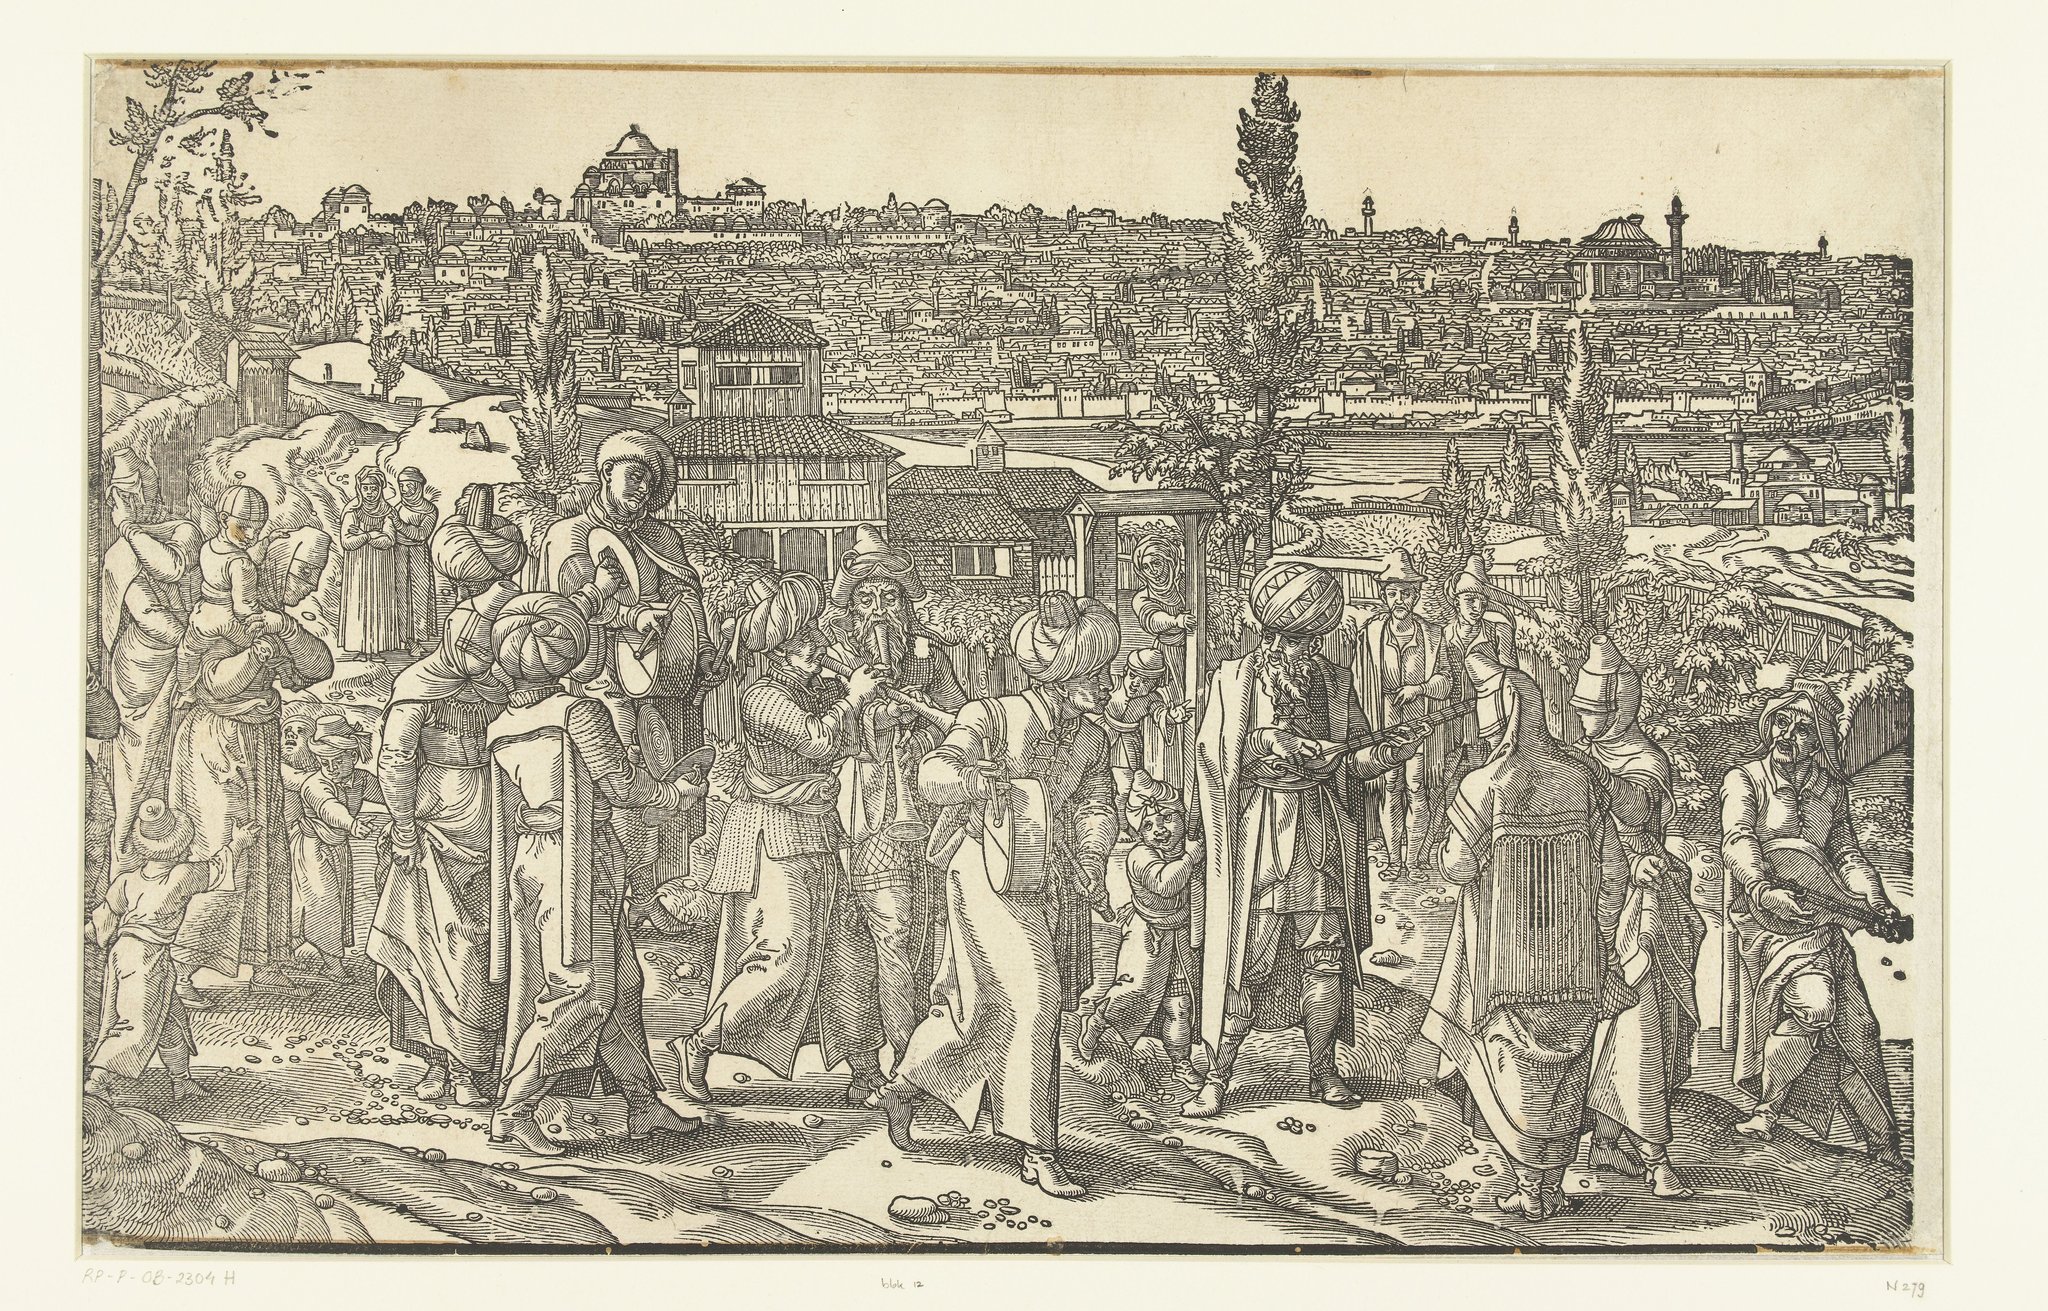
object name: print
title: Bruiloftsoptocht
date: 1553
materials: paper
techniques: woodcut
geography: low countries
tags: asiatic races and peoples: turks, ritual music and dancing ~ islam, mohammedanism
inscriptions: collector's mark: Lugt 240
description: Twaalfde blok van veertien, vormen samen een fries van zeven afbeeldingen met de zeden en gewoonten van de Turken. Bruiloftsoptocht met gesluierde vrouwen, kinderen en muzikanten op de heuvels van Kassim-Pasja, met een gezicht op Istanbul.